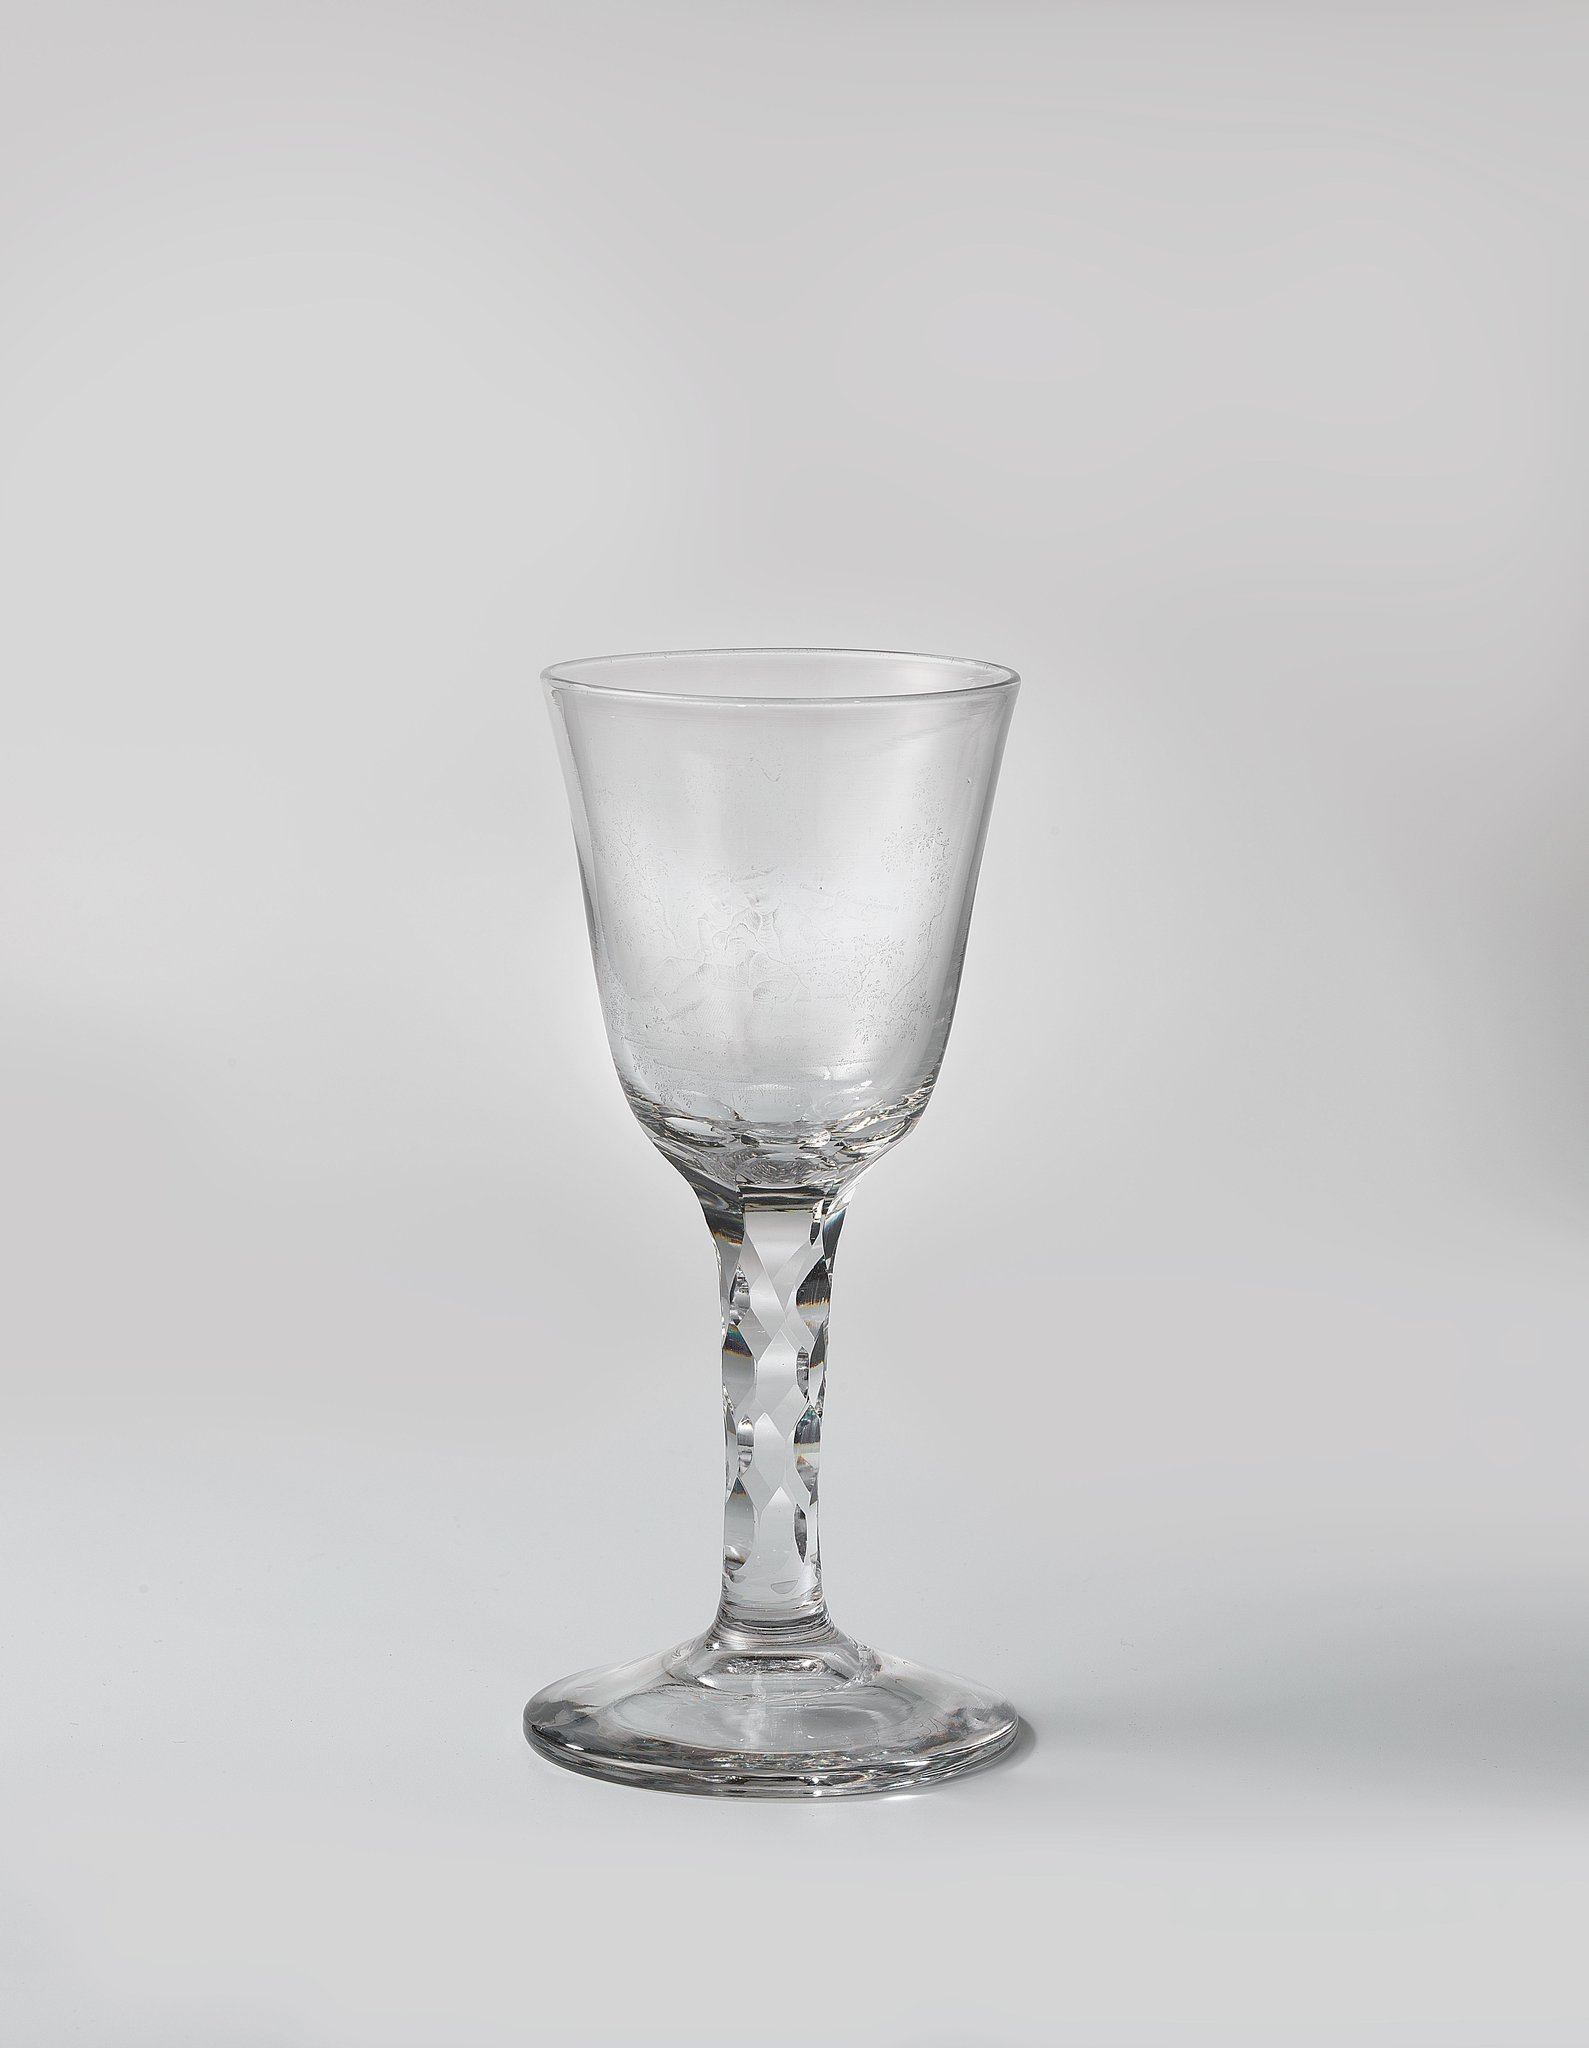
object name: goblet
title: Kelkglas met een fluitspelende jongen in gezelschap van een meisje en jongen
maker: meester alius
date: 1760-1780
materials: glass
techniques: glassblowing, grinding, engraving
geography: the hague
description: Conische voet. Rechte, facetgeslepen stam. Trechtervormige, aan de onderzijde afgeronde kelk. Op de kelk, in een landschap met bomen, een op een bank zittend jongen en meisje. De jongen houdt een blad muziek in de hand. Het meisje kijkt over z'n schouder mee. Achter hen een fluit spelende jongen. Aan weerszijden bomen.